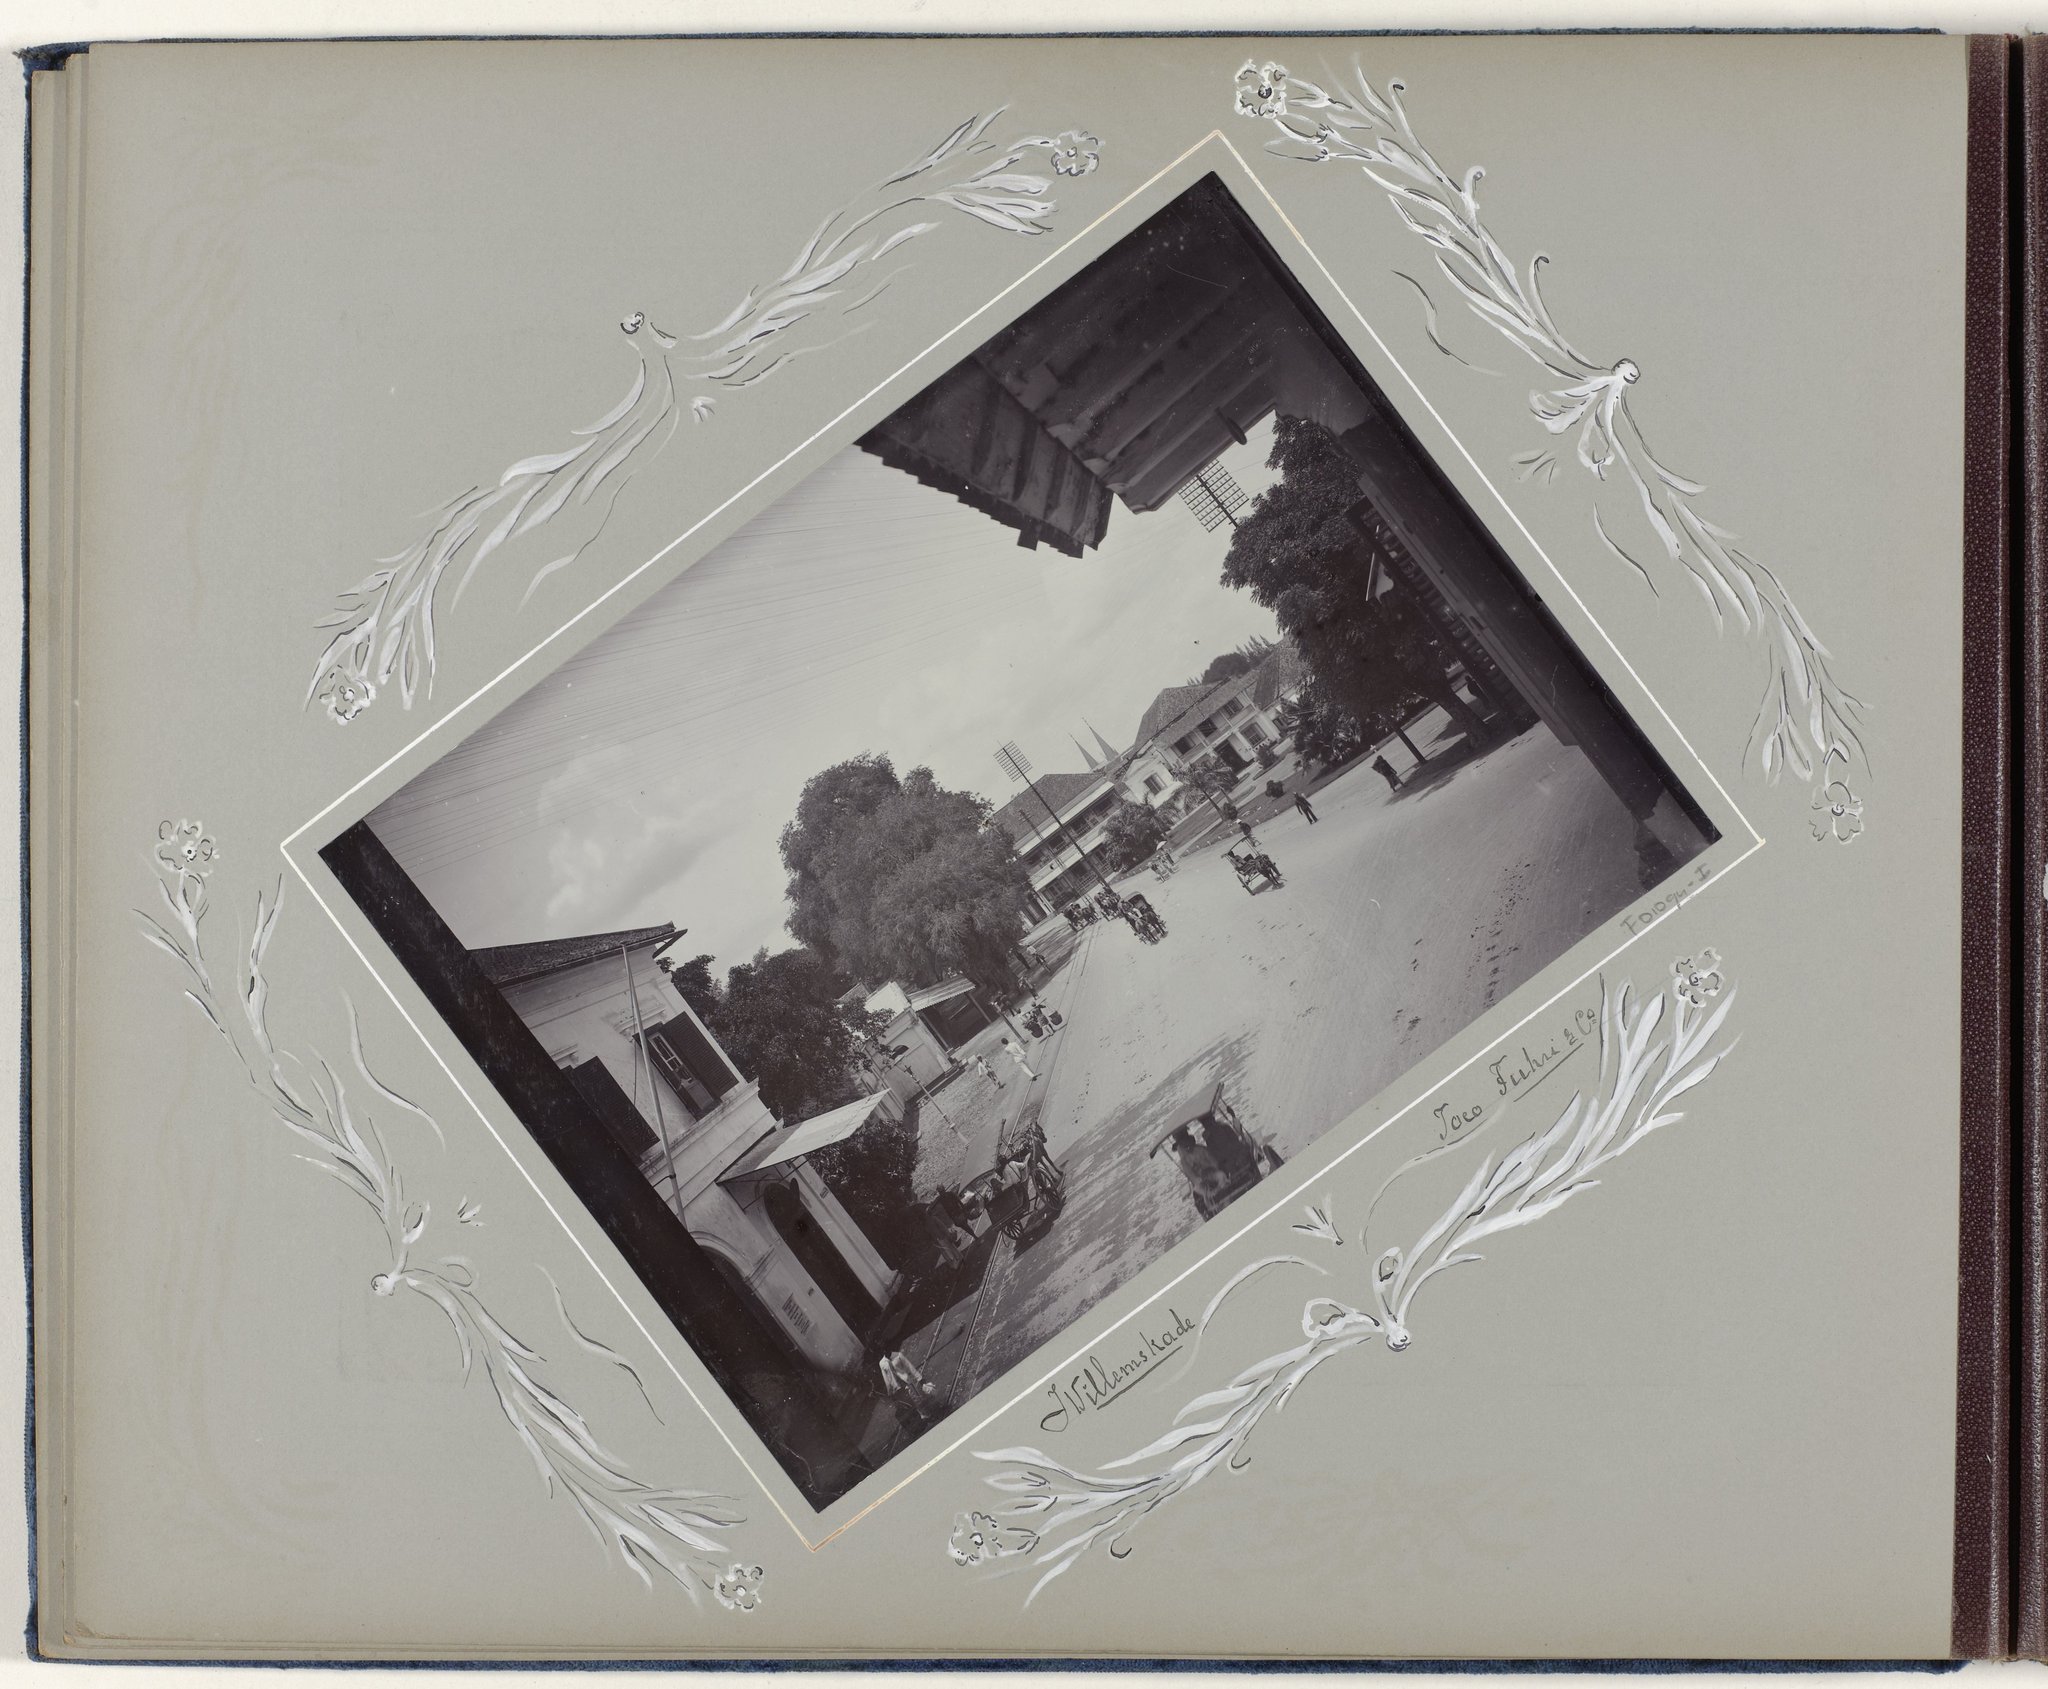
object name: photograph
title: Willemskade Toco Fuhri en Co.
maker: Anonymous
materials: cardboard, paper, photographic support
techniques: gelatin silver print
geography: surabaya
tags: carrying something with carrying-pole, two-wheeled, animal-drawn vehicle, street (+ city(-scape) with figures, staffage), surabaya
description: Onderdeel van Herinneringsalbum met foto's van Soerabaja.